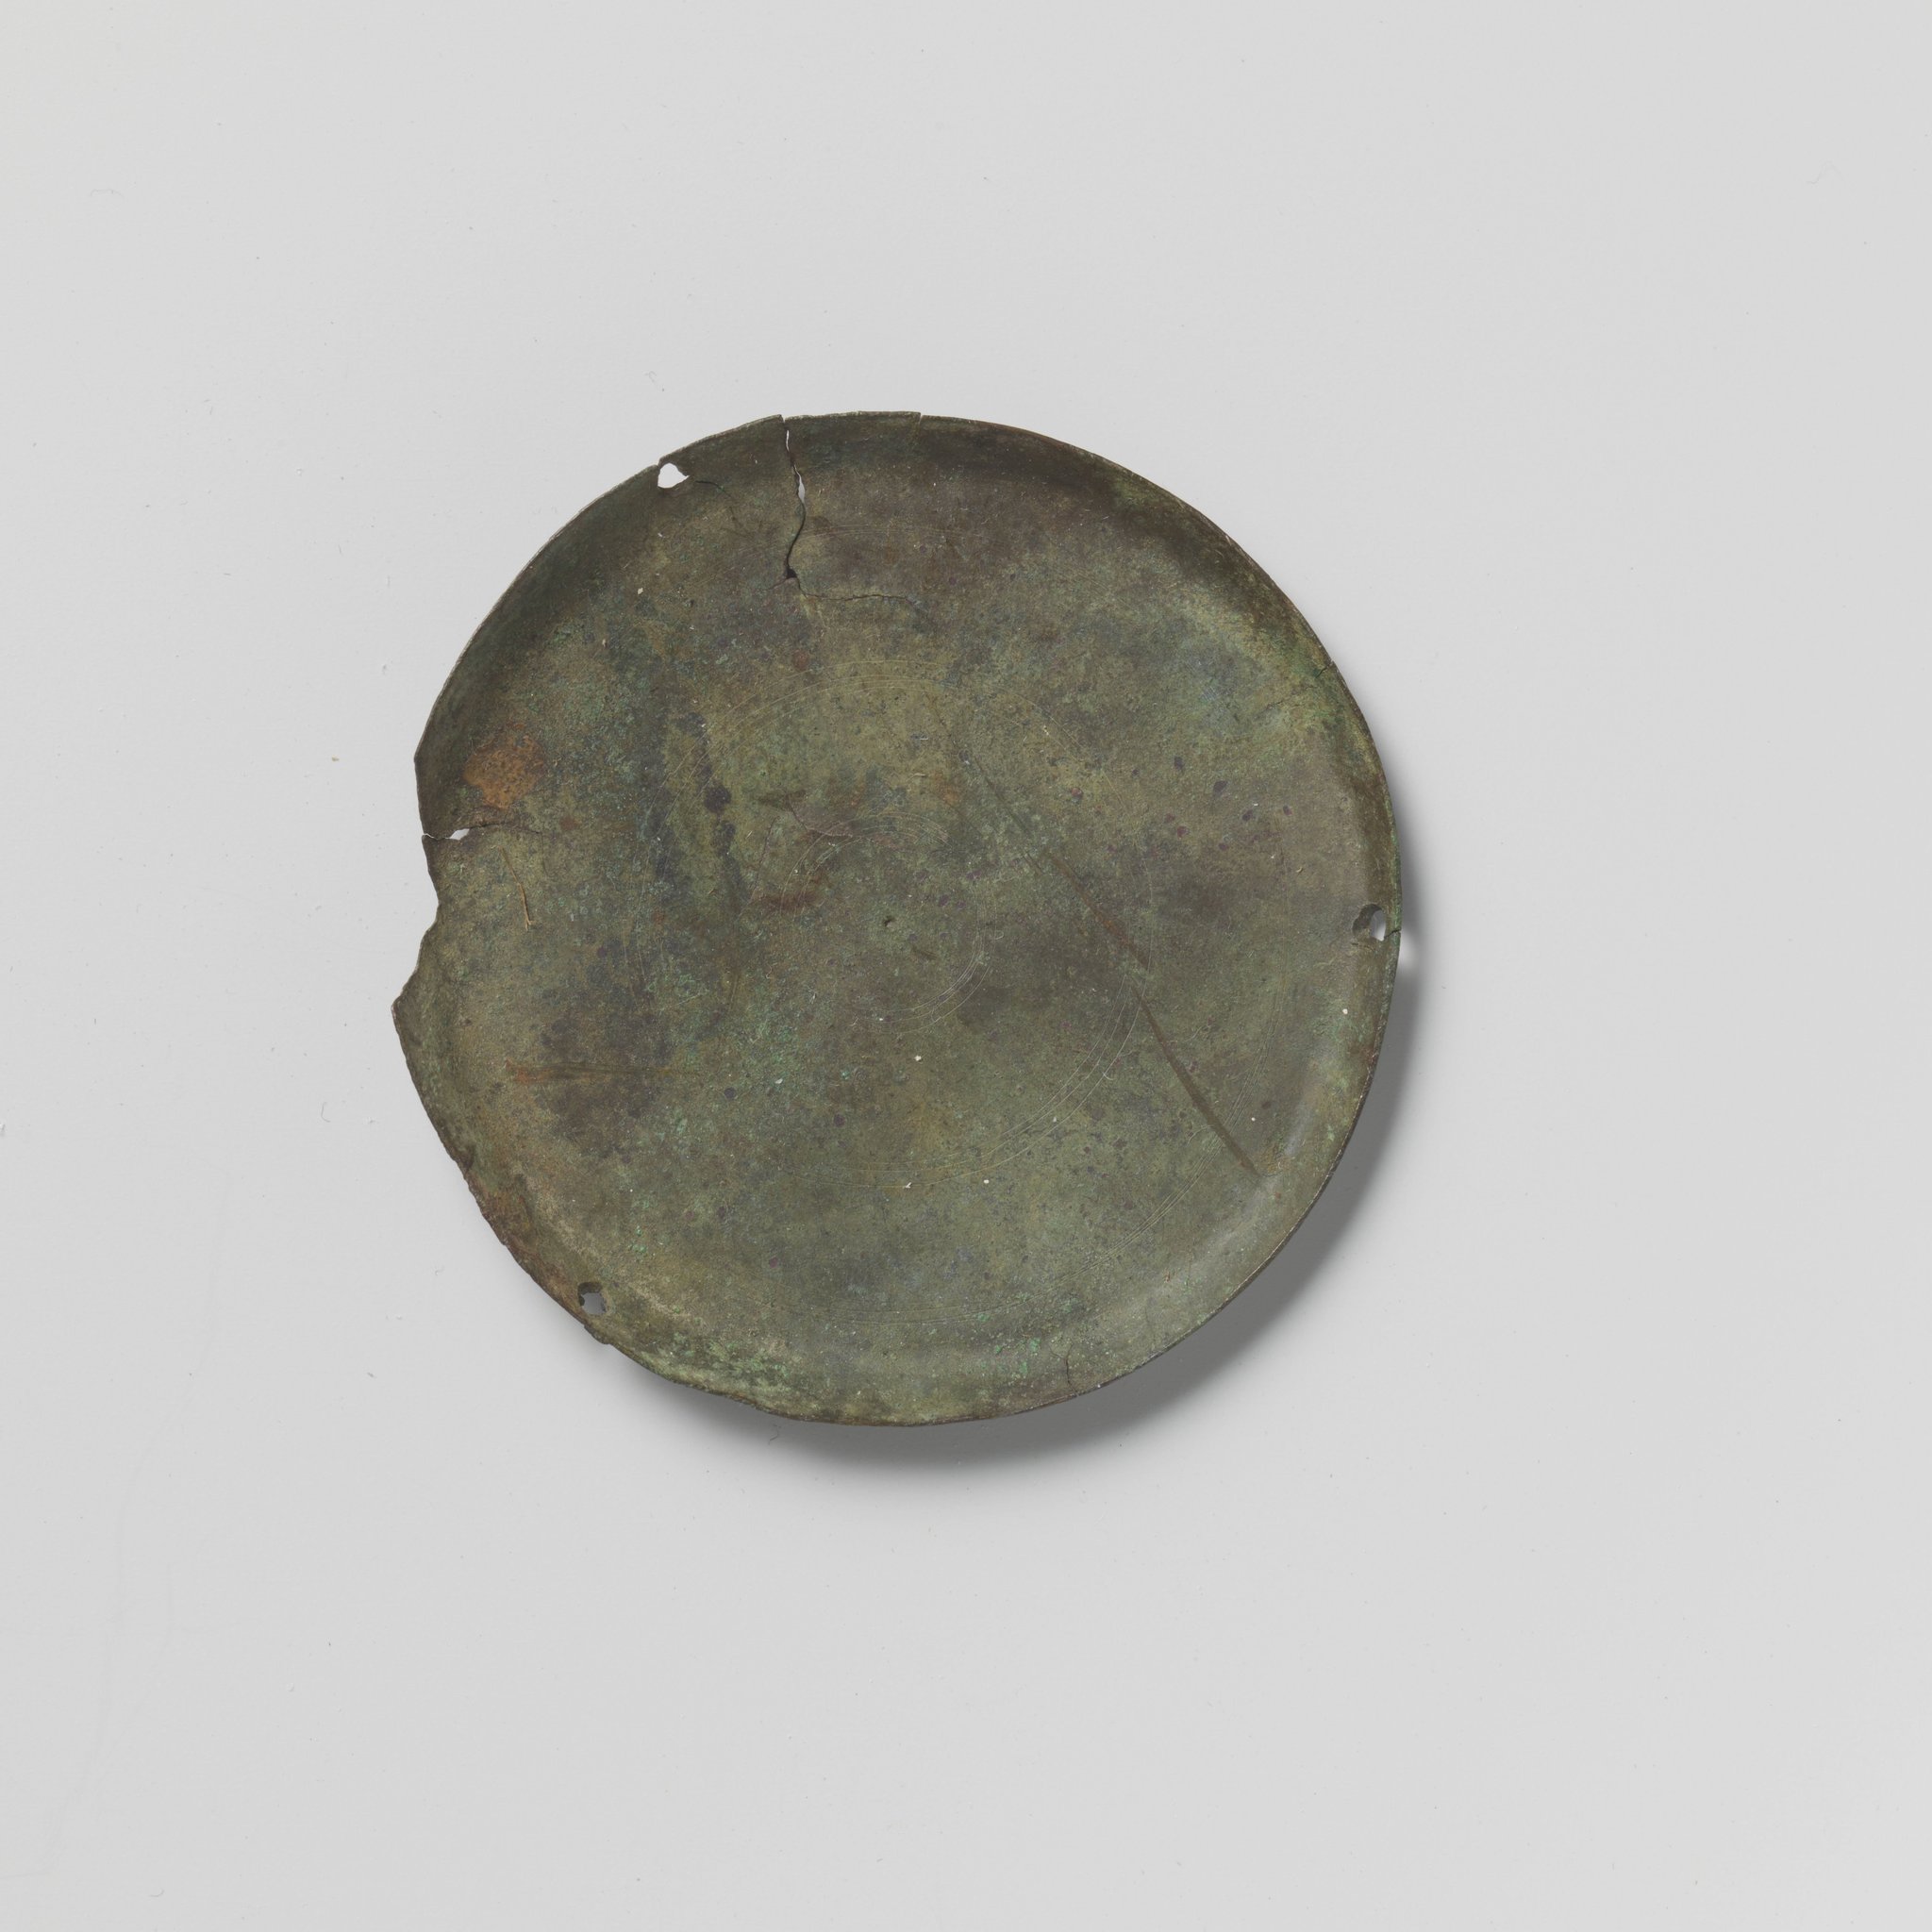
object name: weegschaal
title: Weegschaal van koper, rond en plat met opstaand randje waarin drie gaatjes zijn aangebracht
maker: Anonymous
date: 1590-1596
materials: copper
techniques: striking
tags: willem barendsz., amsterdam, jacob van heemskerck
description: Weegschaaltje van koper, rond en plat met opstaand randje waarin drie gaatjes zijn aangebracht. Waarschijnlijk heeft de weegschaal gediend voor het afwegen van geneesmiddelen. Volgens De Veer is er een barbier of chirurgijn meegeweest met de tocht.